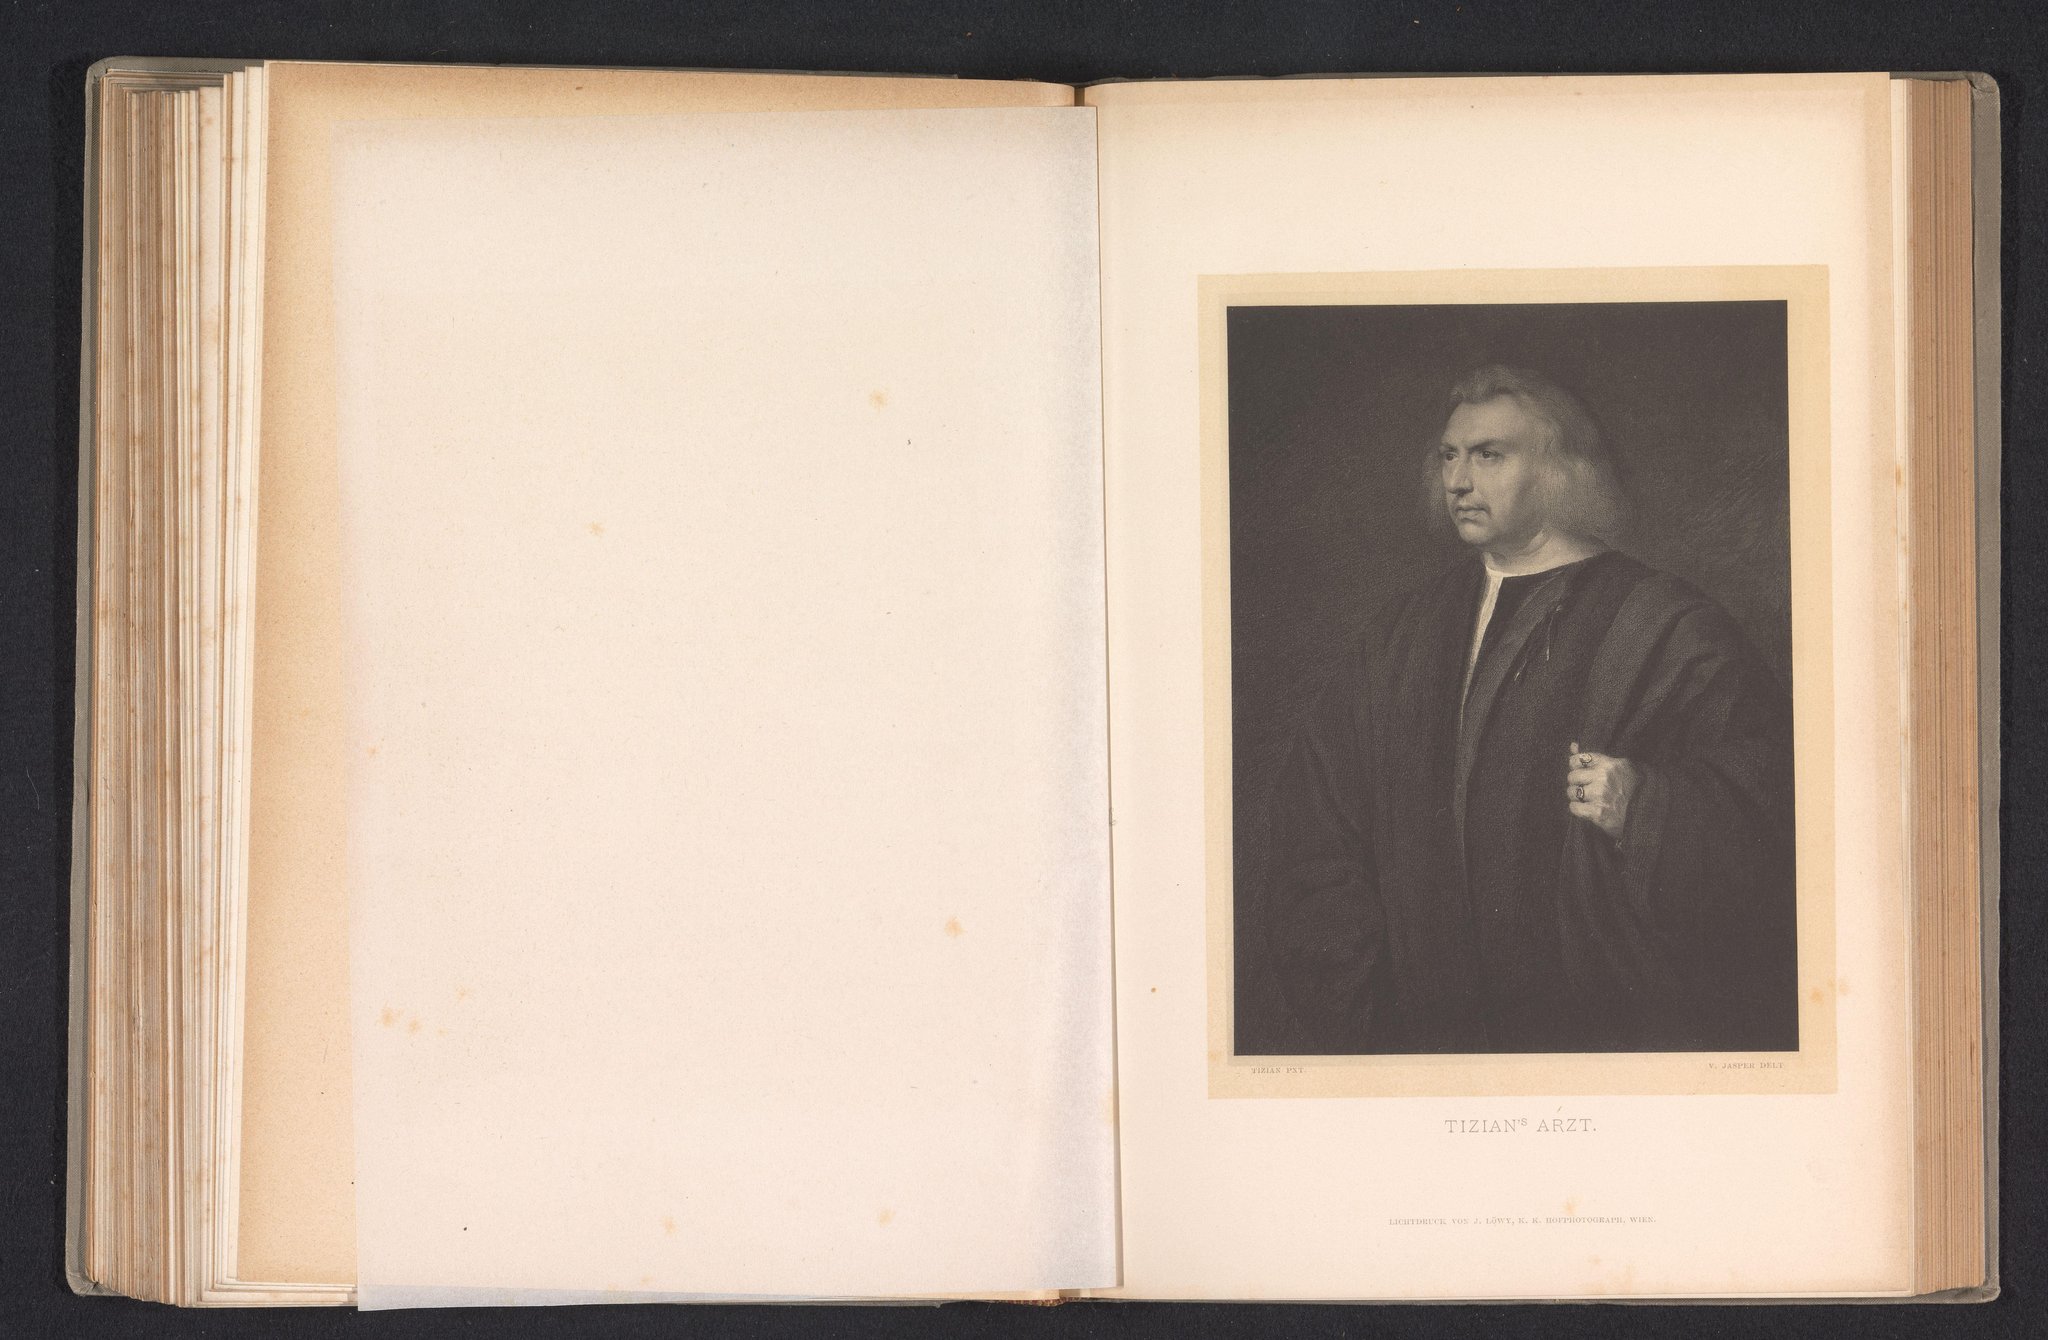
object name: photomechanical print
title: Fotoreproductie van een tekening naar een schilderij, voorstellende een portret van de arts Gian Giacomo Bartolotti da Parma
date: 1878-1883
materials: paper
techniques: photograph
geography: vienna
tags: physician, doctor